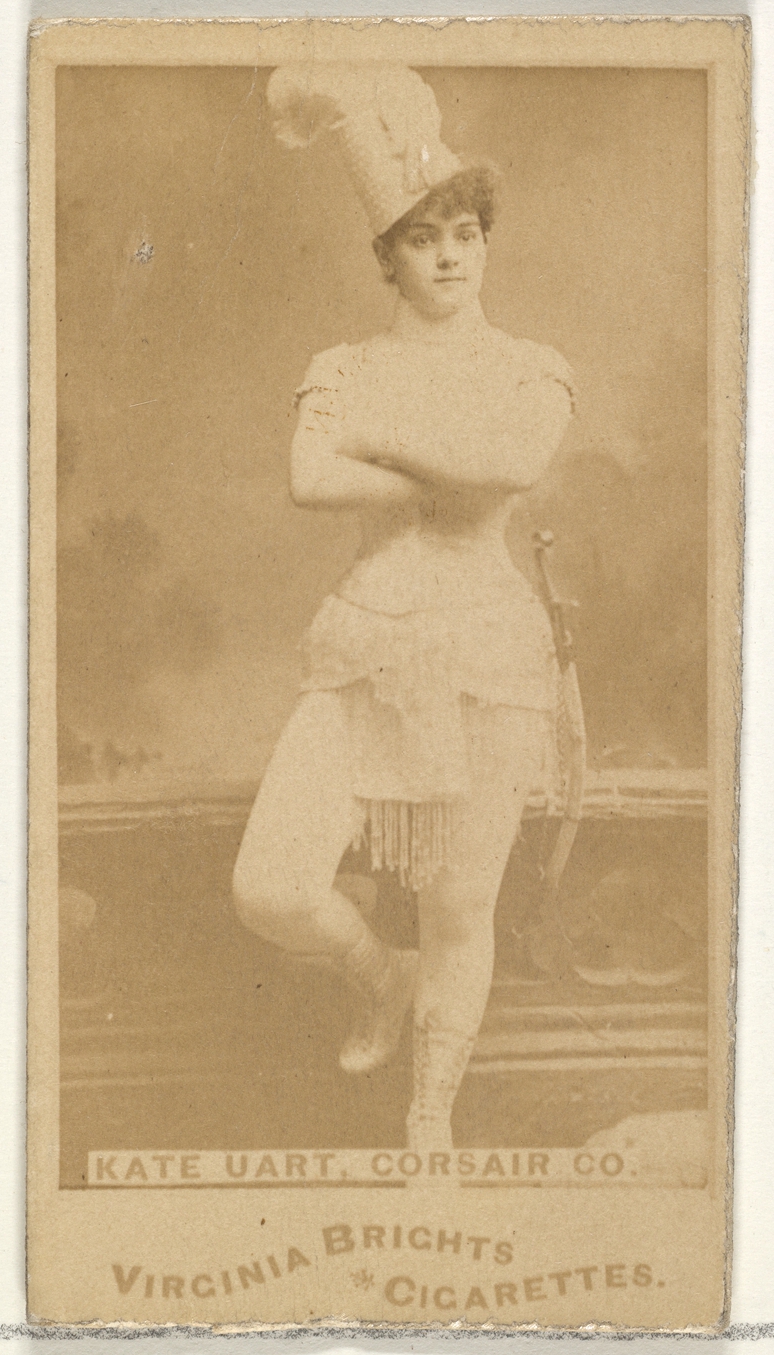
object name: photograph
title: Kate Uart, Corsair Co., from the Actors and Actresses series (N45, Type 1) for Virginia Brights Cigarettes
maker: allen & ginter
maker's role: publisher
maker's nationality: american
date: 1888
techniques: albumen silver print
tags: portraits,women,actresses